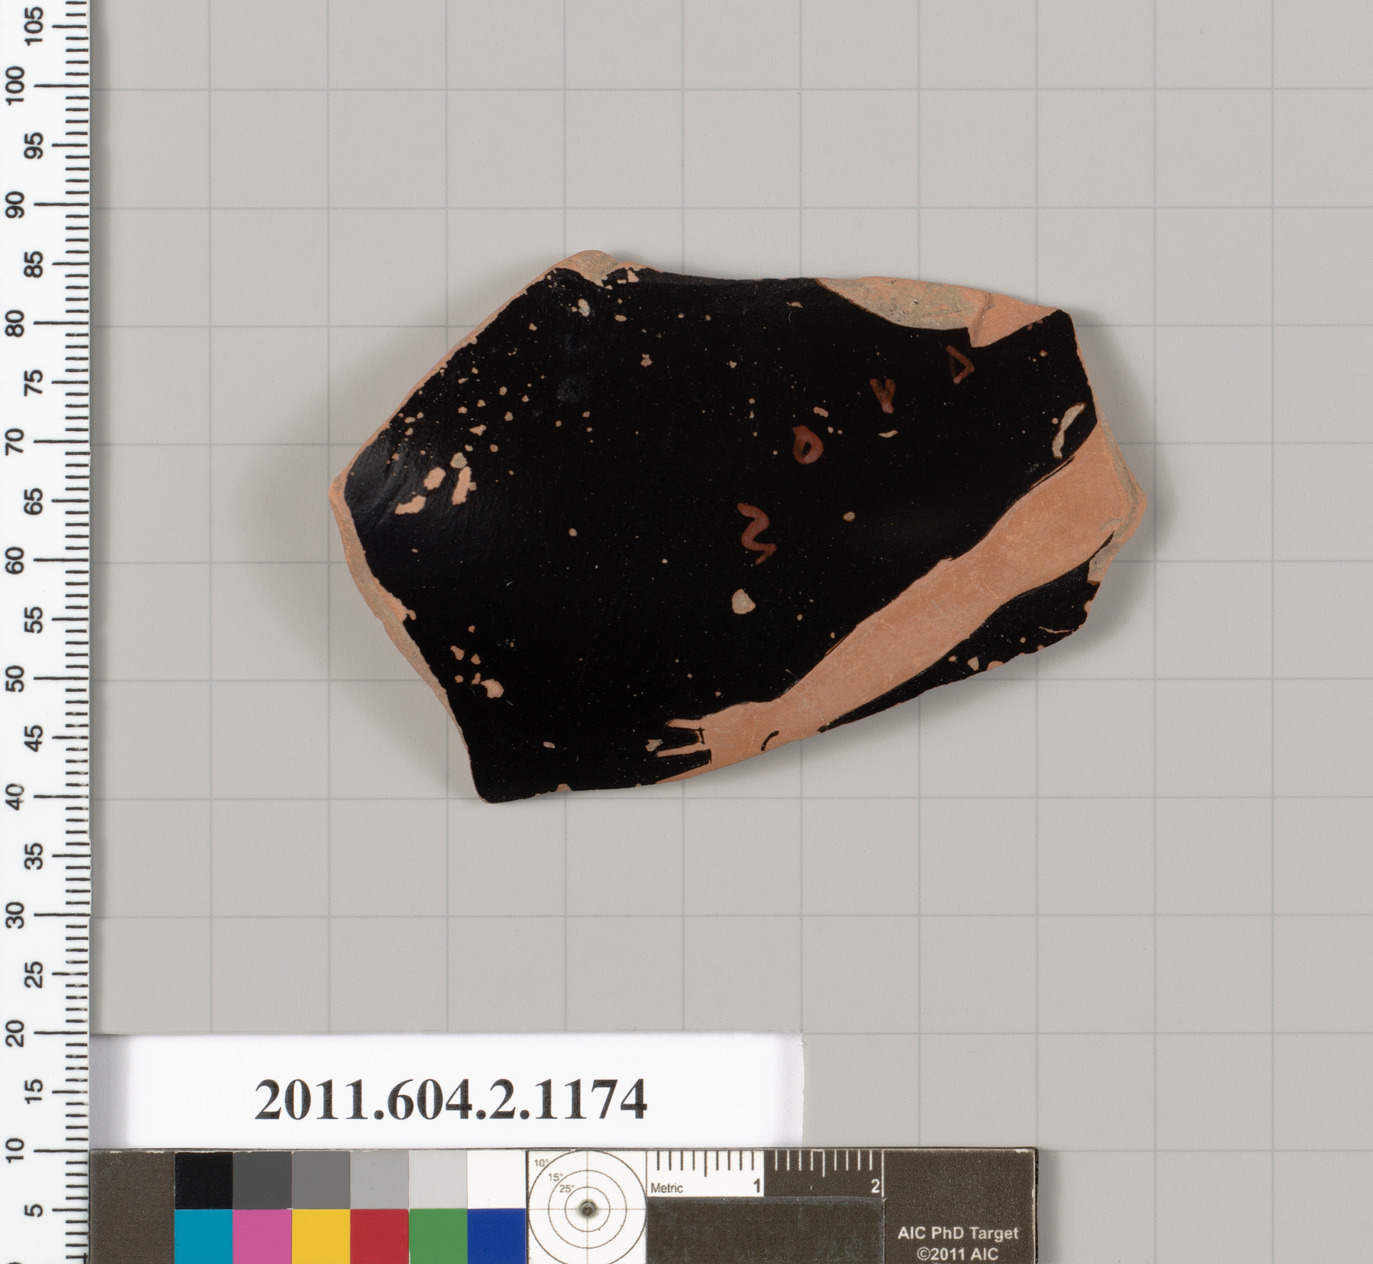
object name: kalpis fragment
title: Terracotta fragment of a hydria: kalpis (water jar)?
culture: greek, attic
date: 475-451 BCE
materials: terracotta